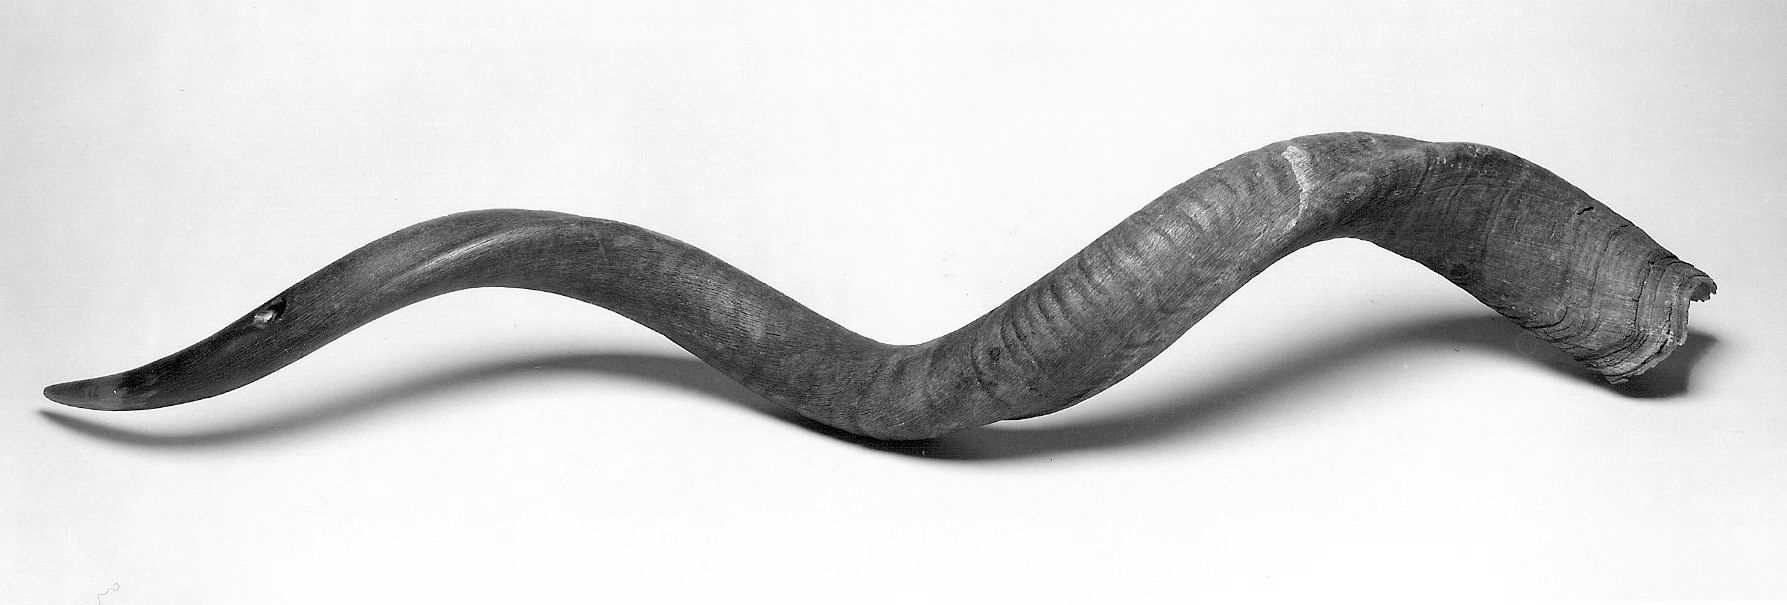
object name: kudu horn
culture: south african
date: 1867-1900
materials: horn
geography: south africa